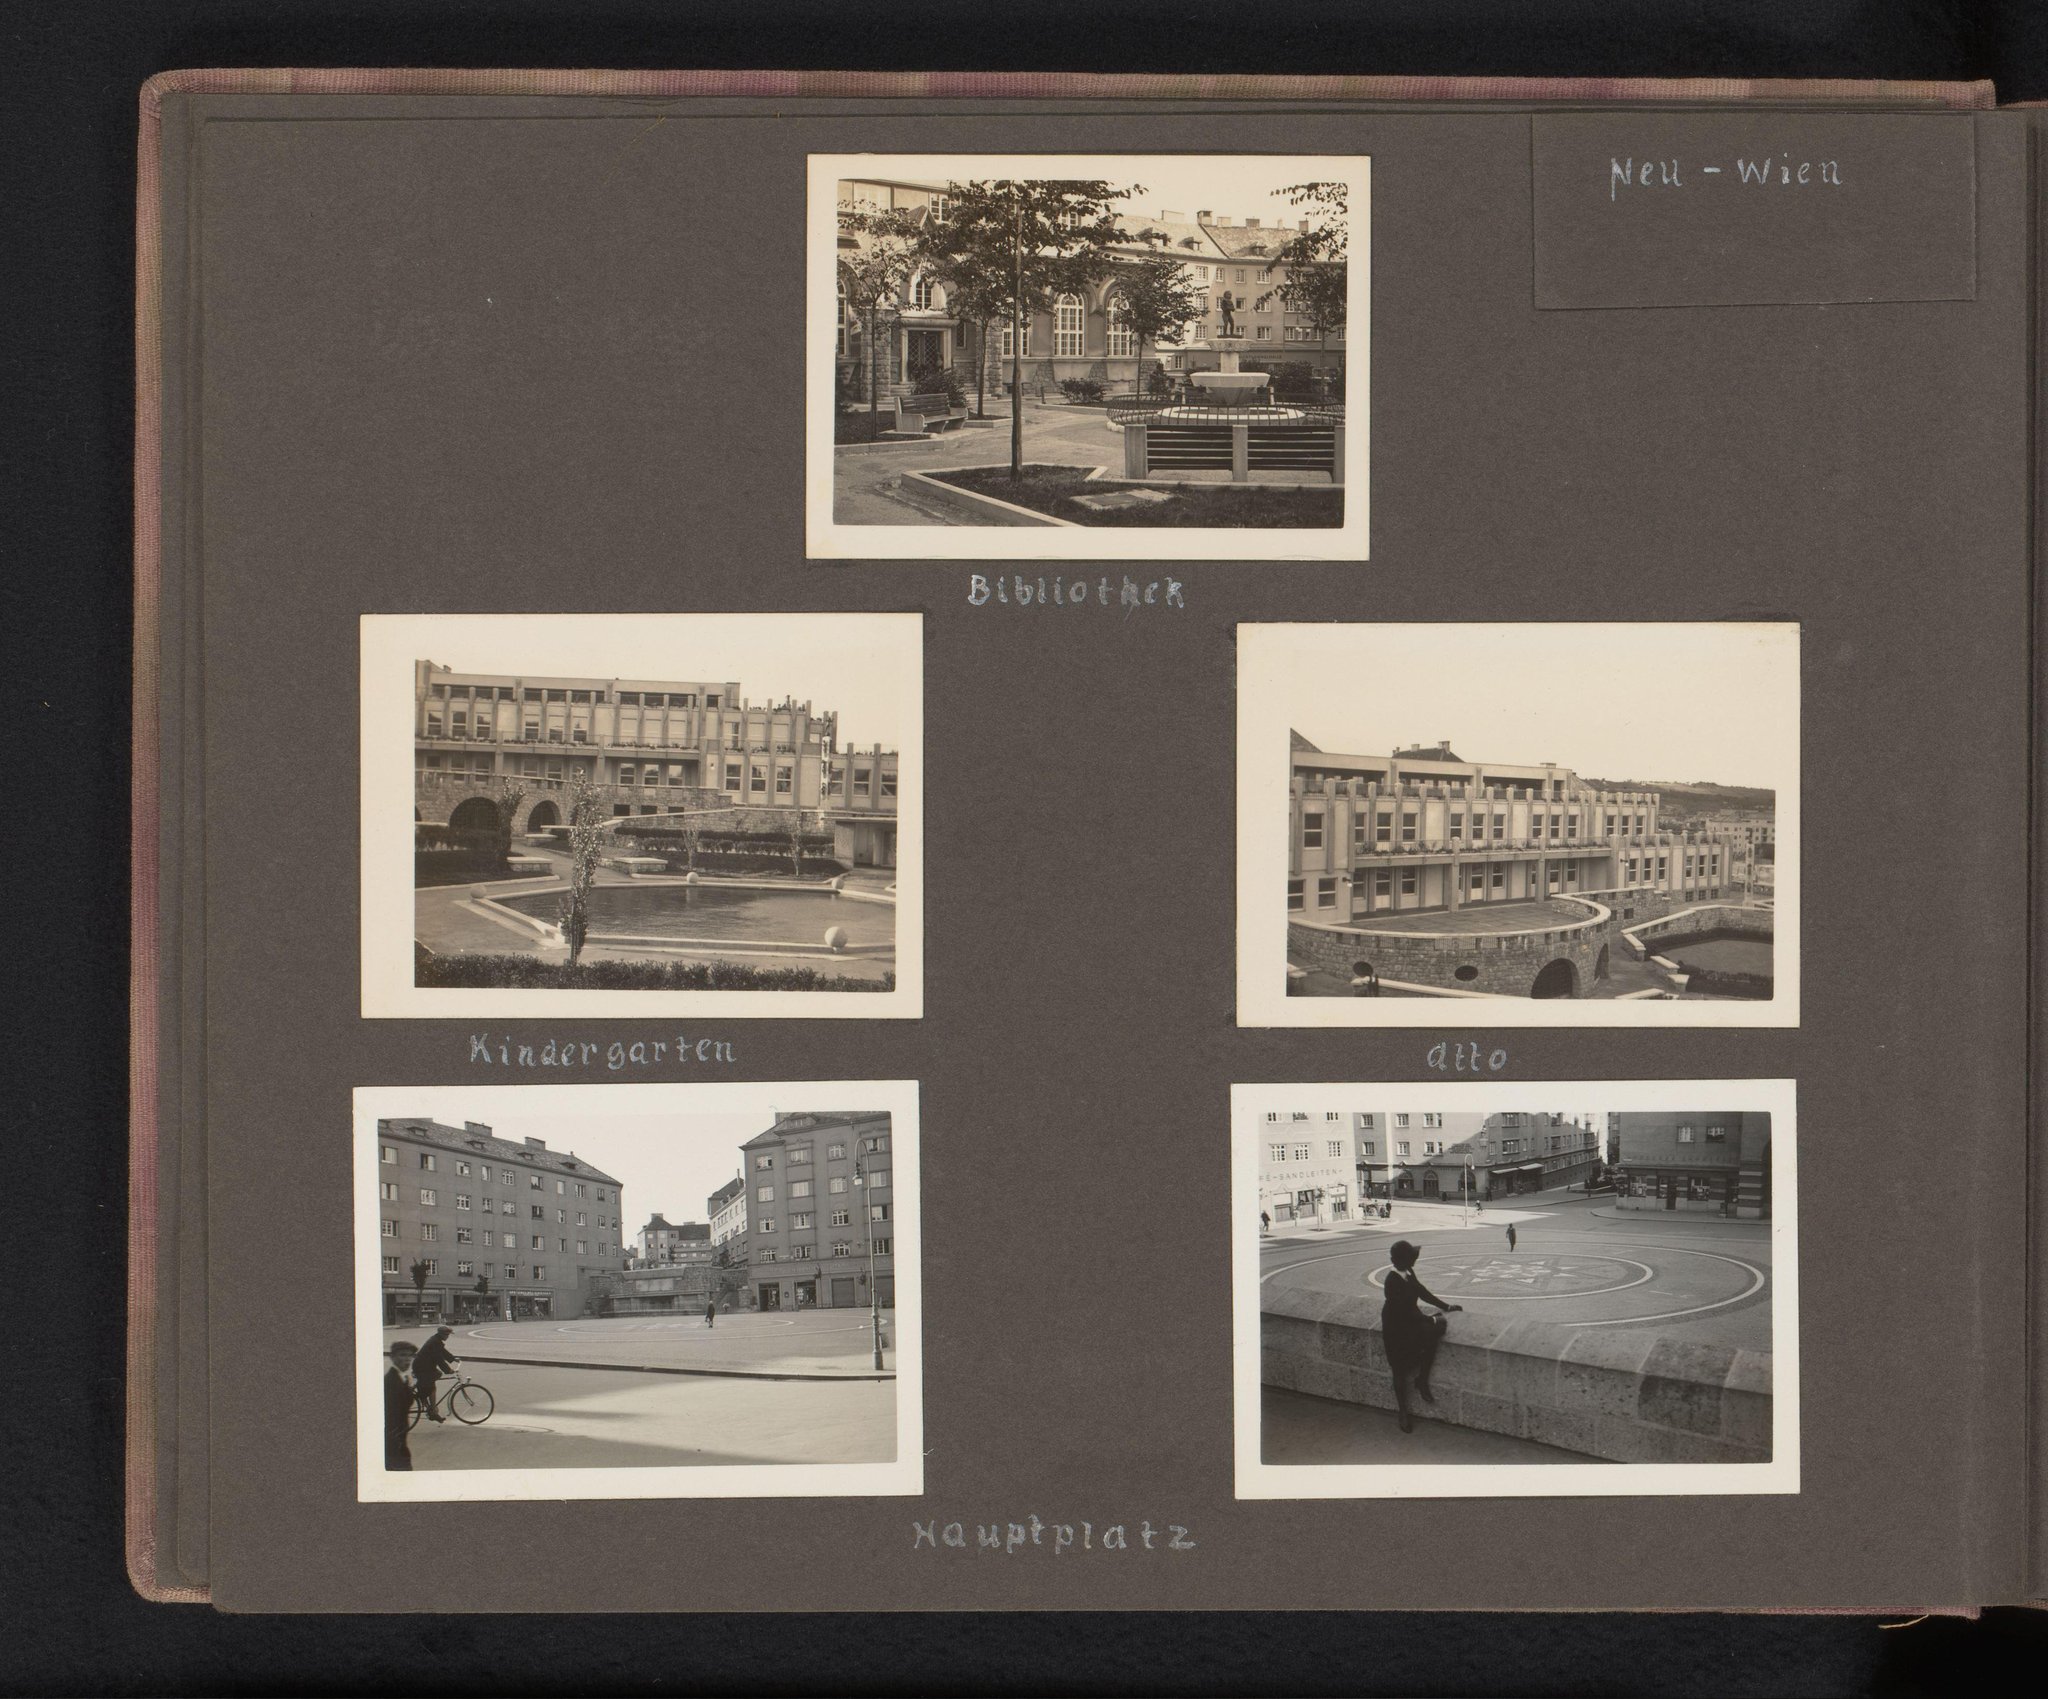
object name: photograph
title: Vijf gezichten op Neu-Wien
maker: berti hoppe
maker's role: fotograaf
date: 1930-1931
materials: cardboard, photographic support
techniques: gelatin silver print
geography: vienna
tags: public library, nursery school, square, place, circus, etc. (+ city(-scape) with figures, staffage), vienna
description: In de onderschriften is vermeld dat het gaat om een bibliotheek, een kleuterschool, Atto en twee gezichten op de Hauptplatz. Deze foto's maken deel uit van een album.